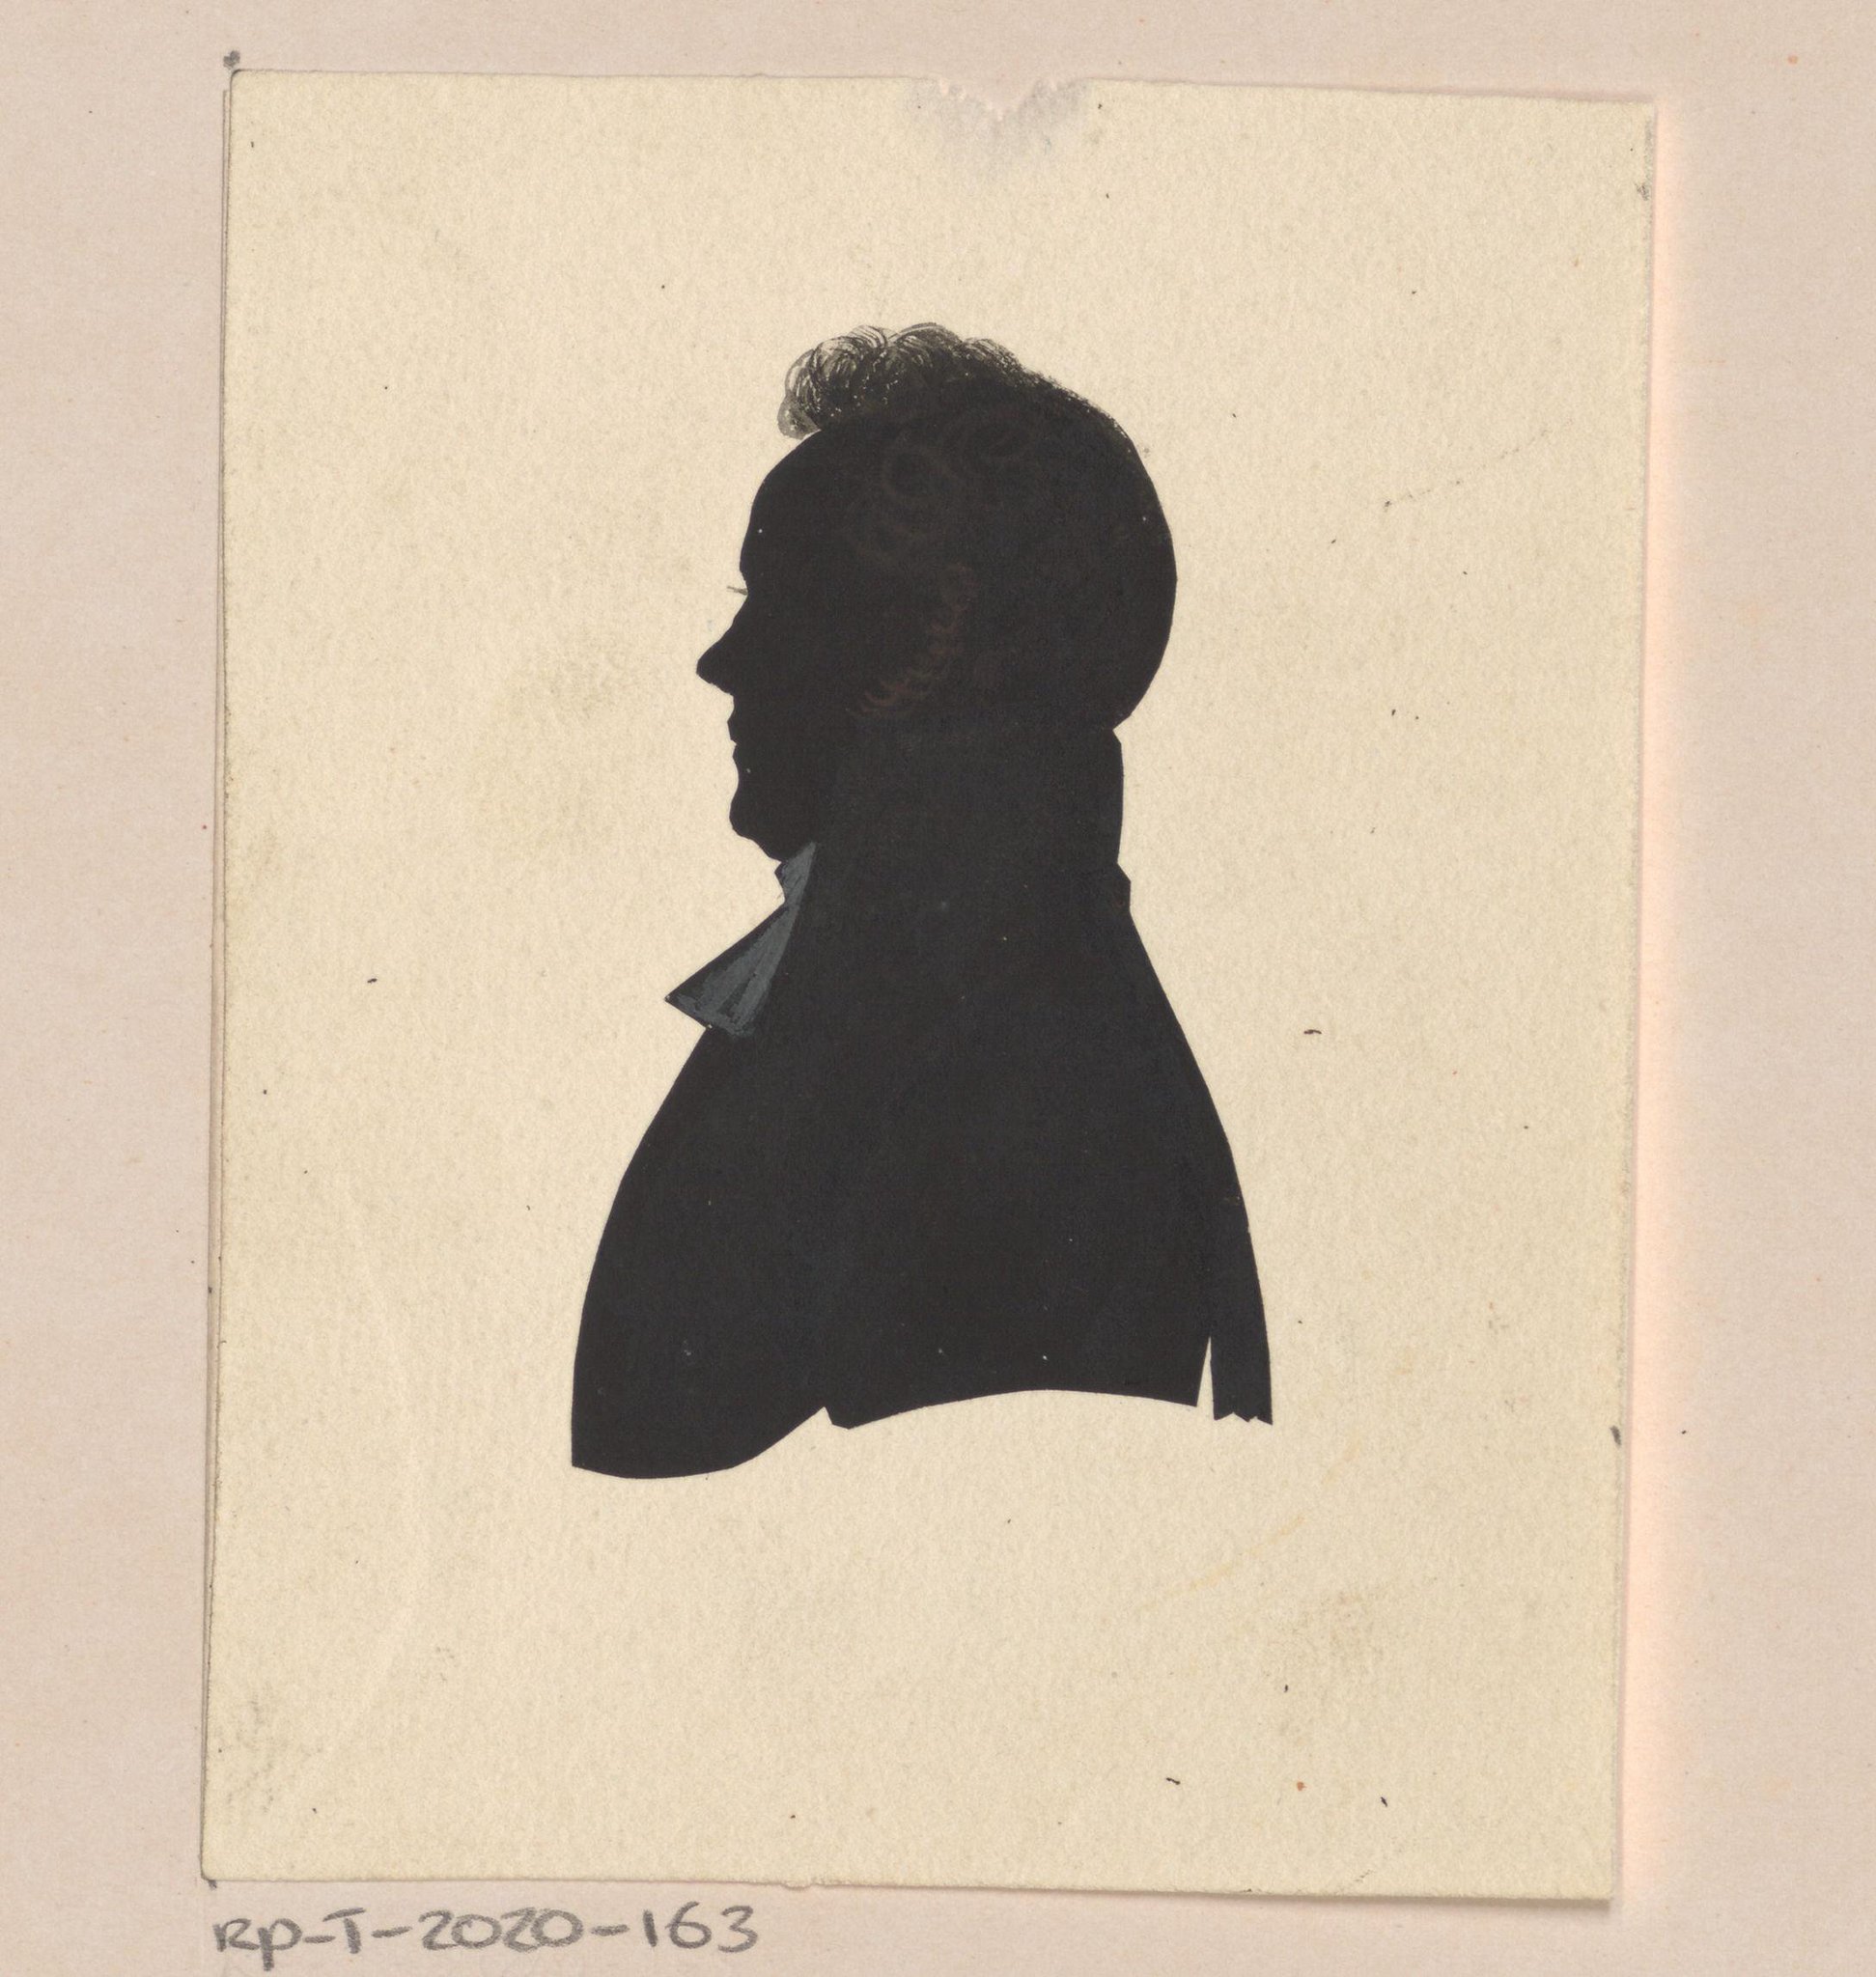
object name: drawing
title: Silhouetportret van Jan Jacob van Voorst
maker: Anonymous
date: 1800-1869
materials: paint, paper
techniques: brush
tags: historical persons